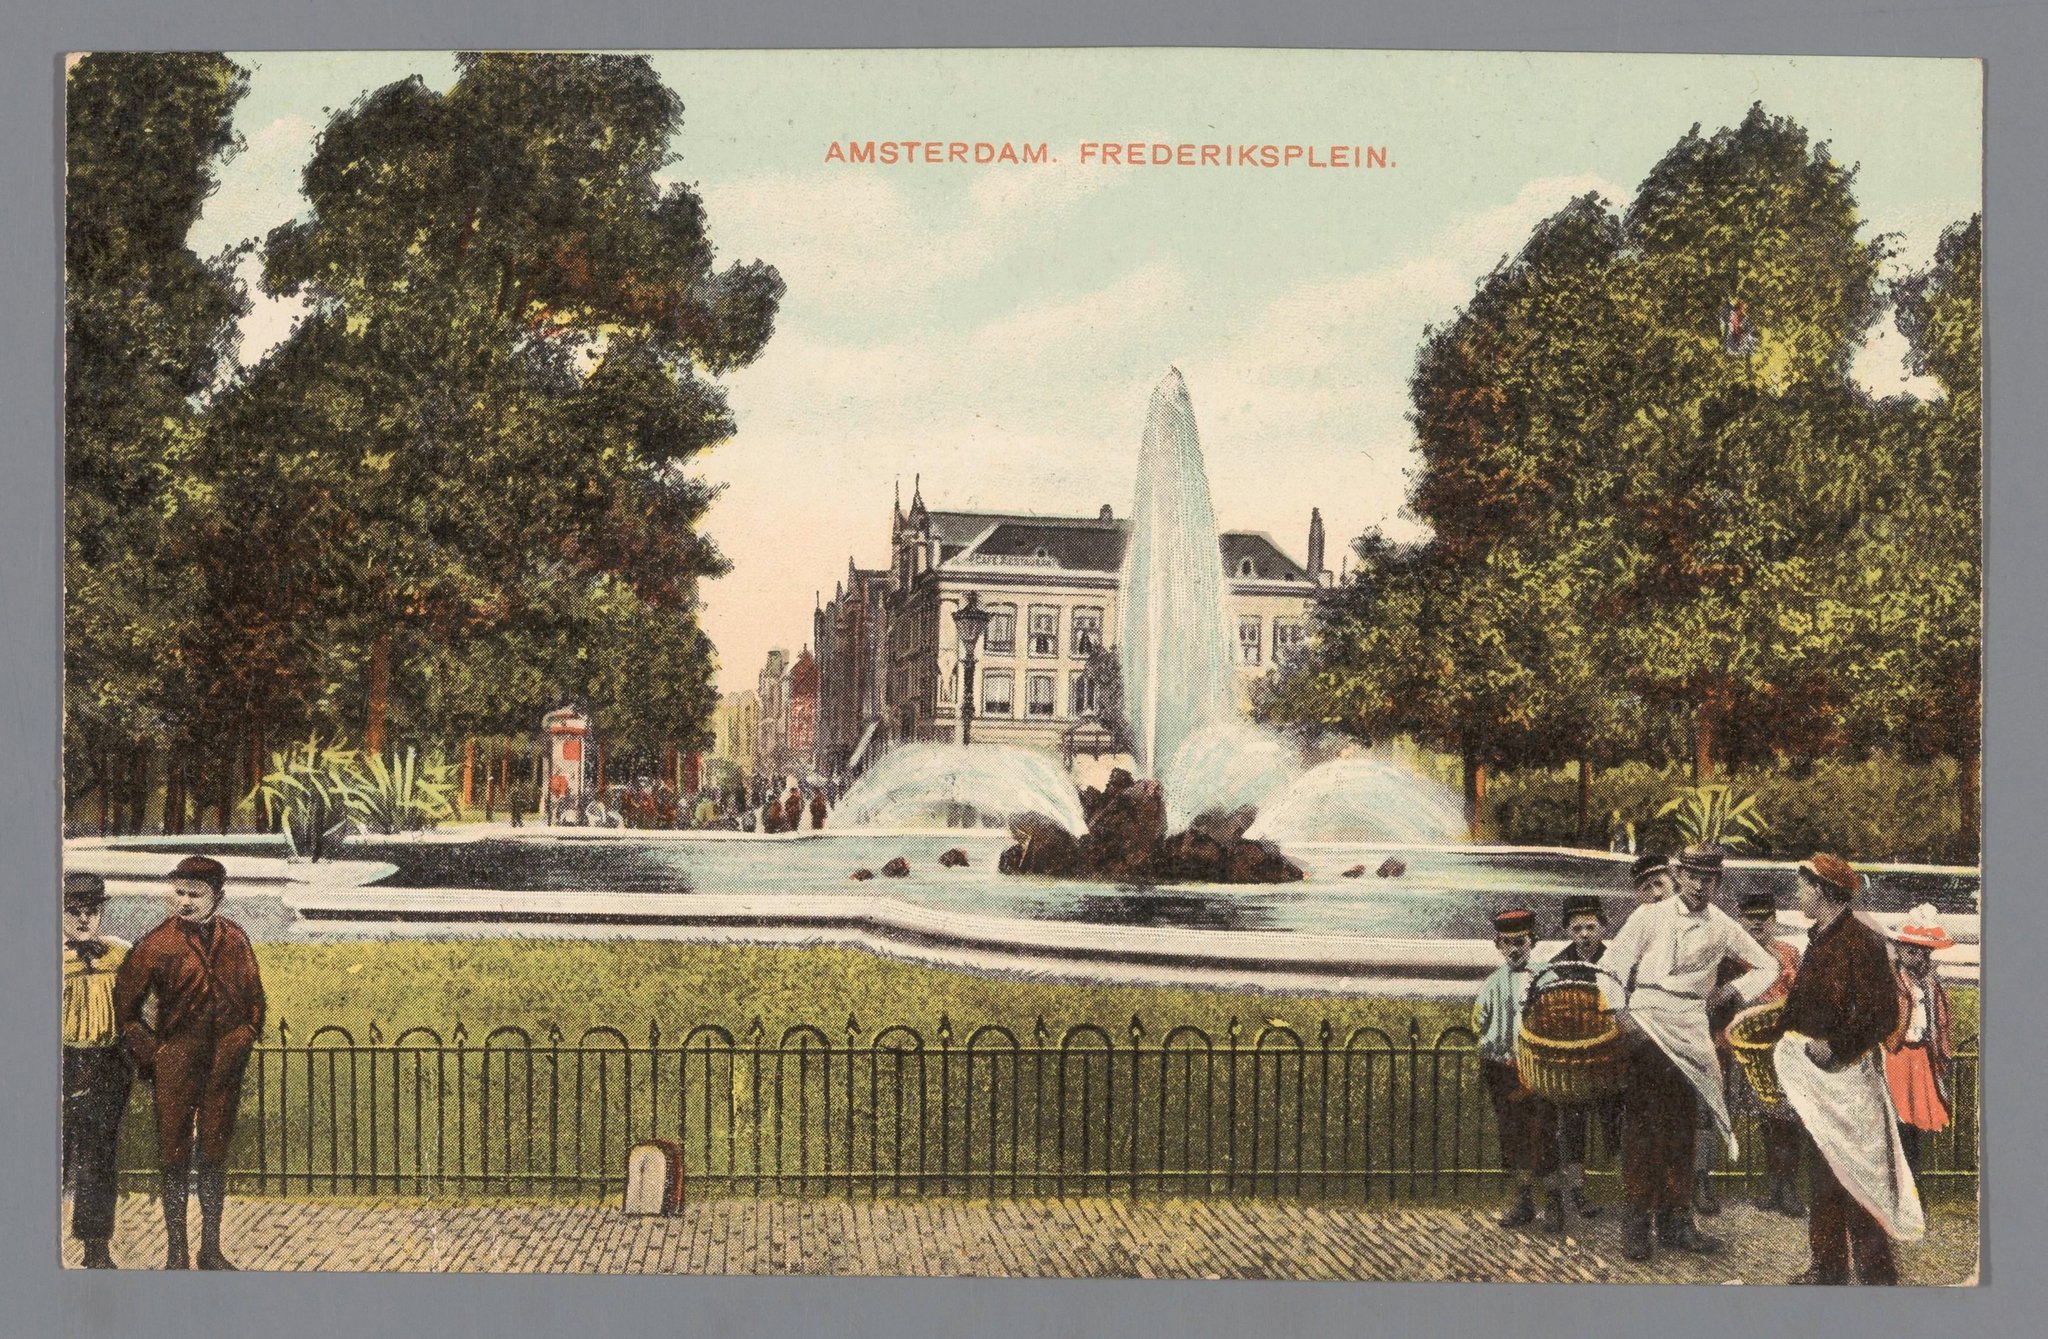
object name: ansichtkaart, prentbriefkaart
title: Amsterdam. Frederiksplein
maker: j.h. schaefer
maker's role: publisher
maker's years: 1853-1949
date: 1900-1920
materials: cardboard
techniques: four-color autotype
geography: amsterdam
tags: ornamental fountain